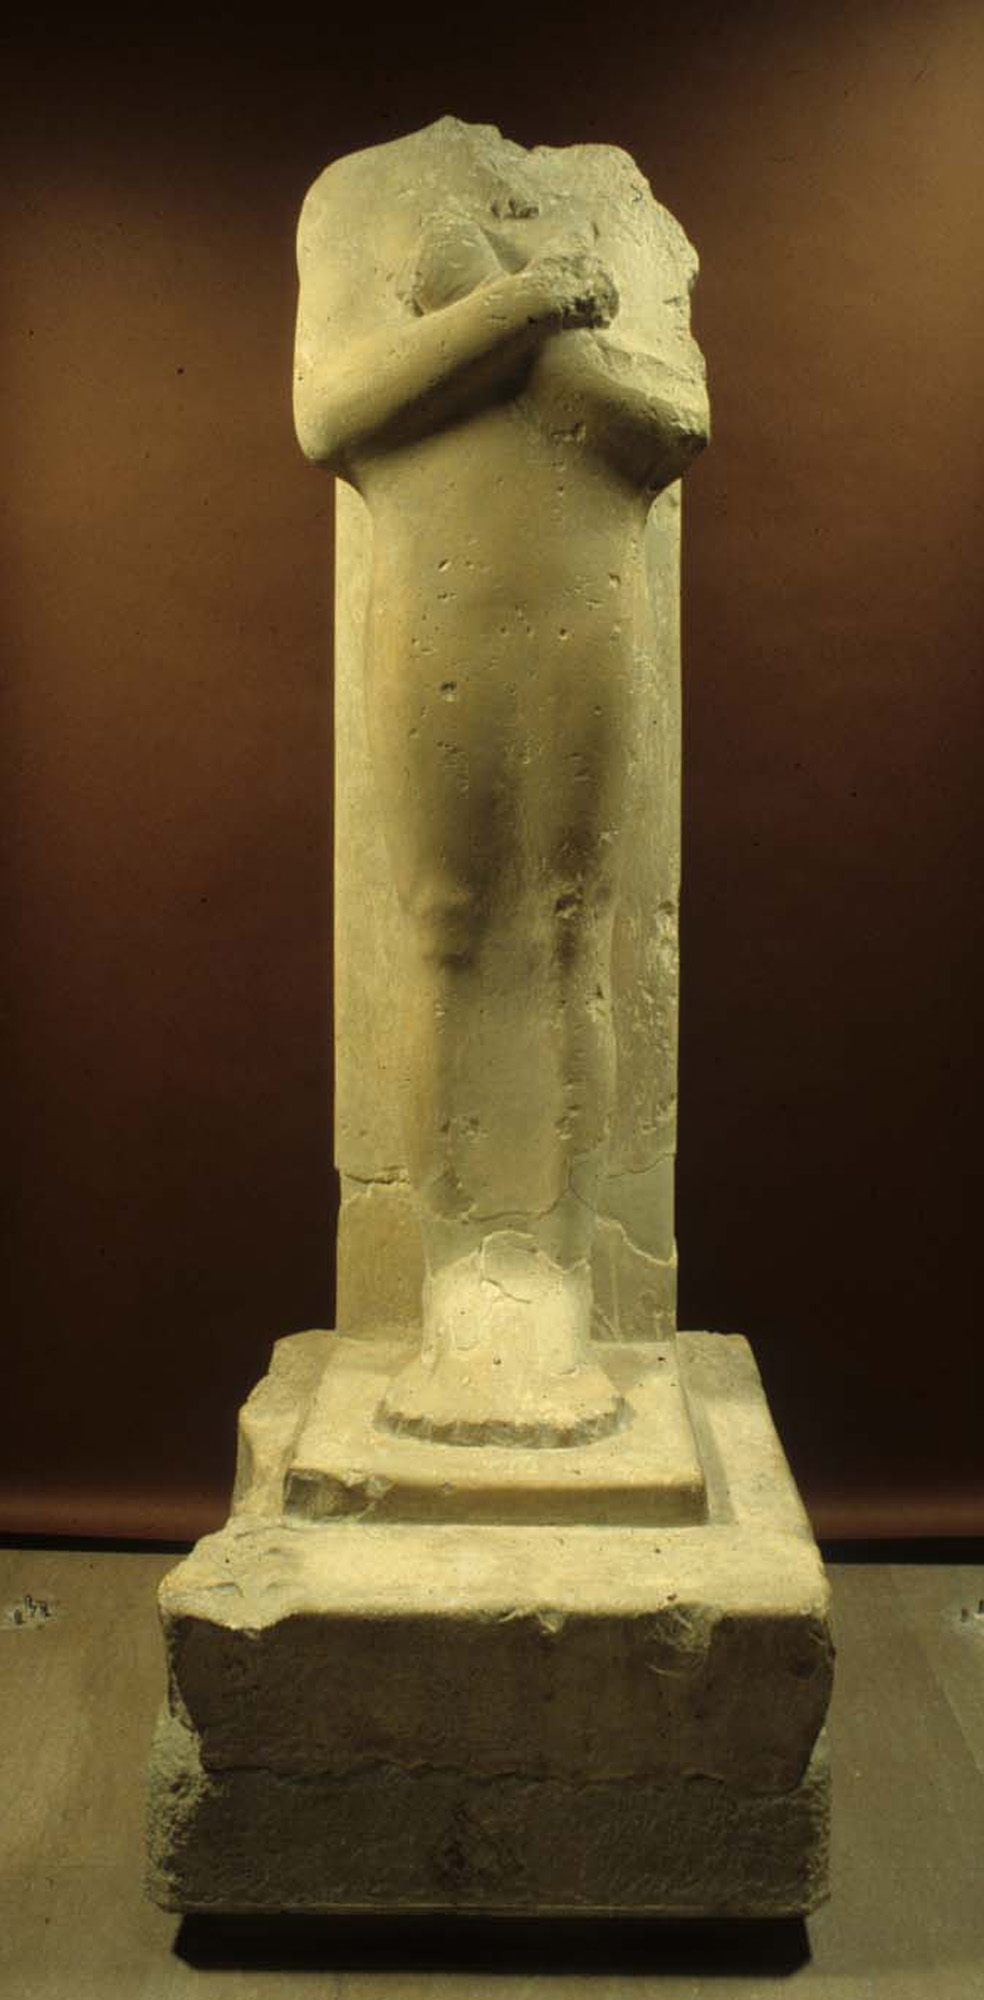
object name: statue, senwosret i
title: Osiride statue of Senwosret I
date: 1961-1917 BCE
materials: limestone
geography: egypt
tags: men